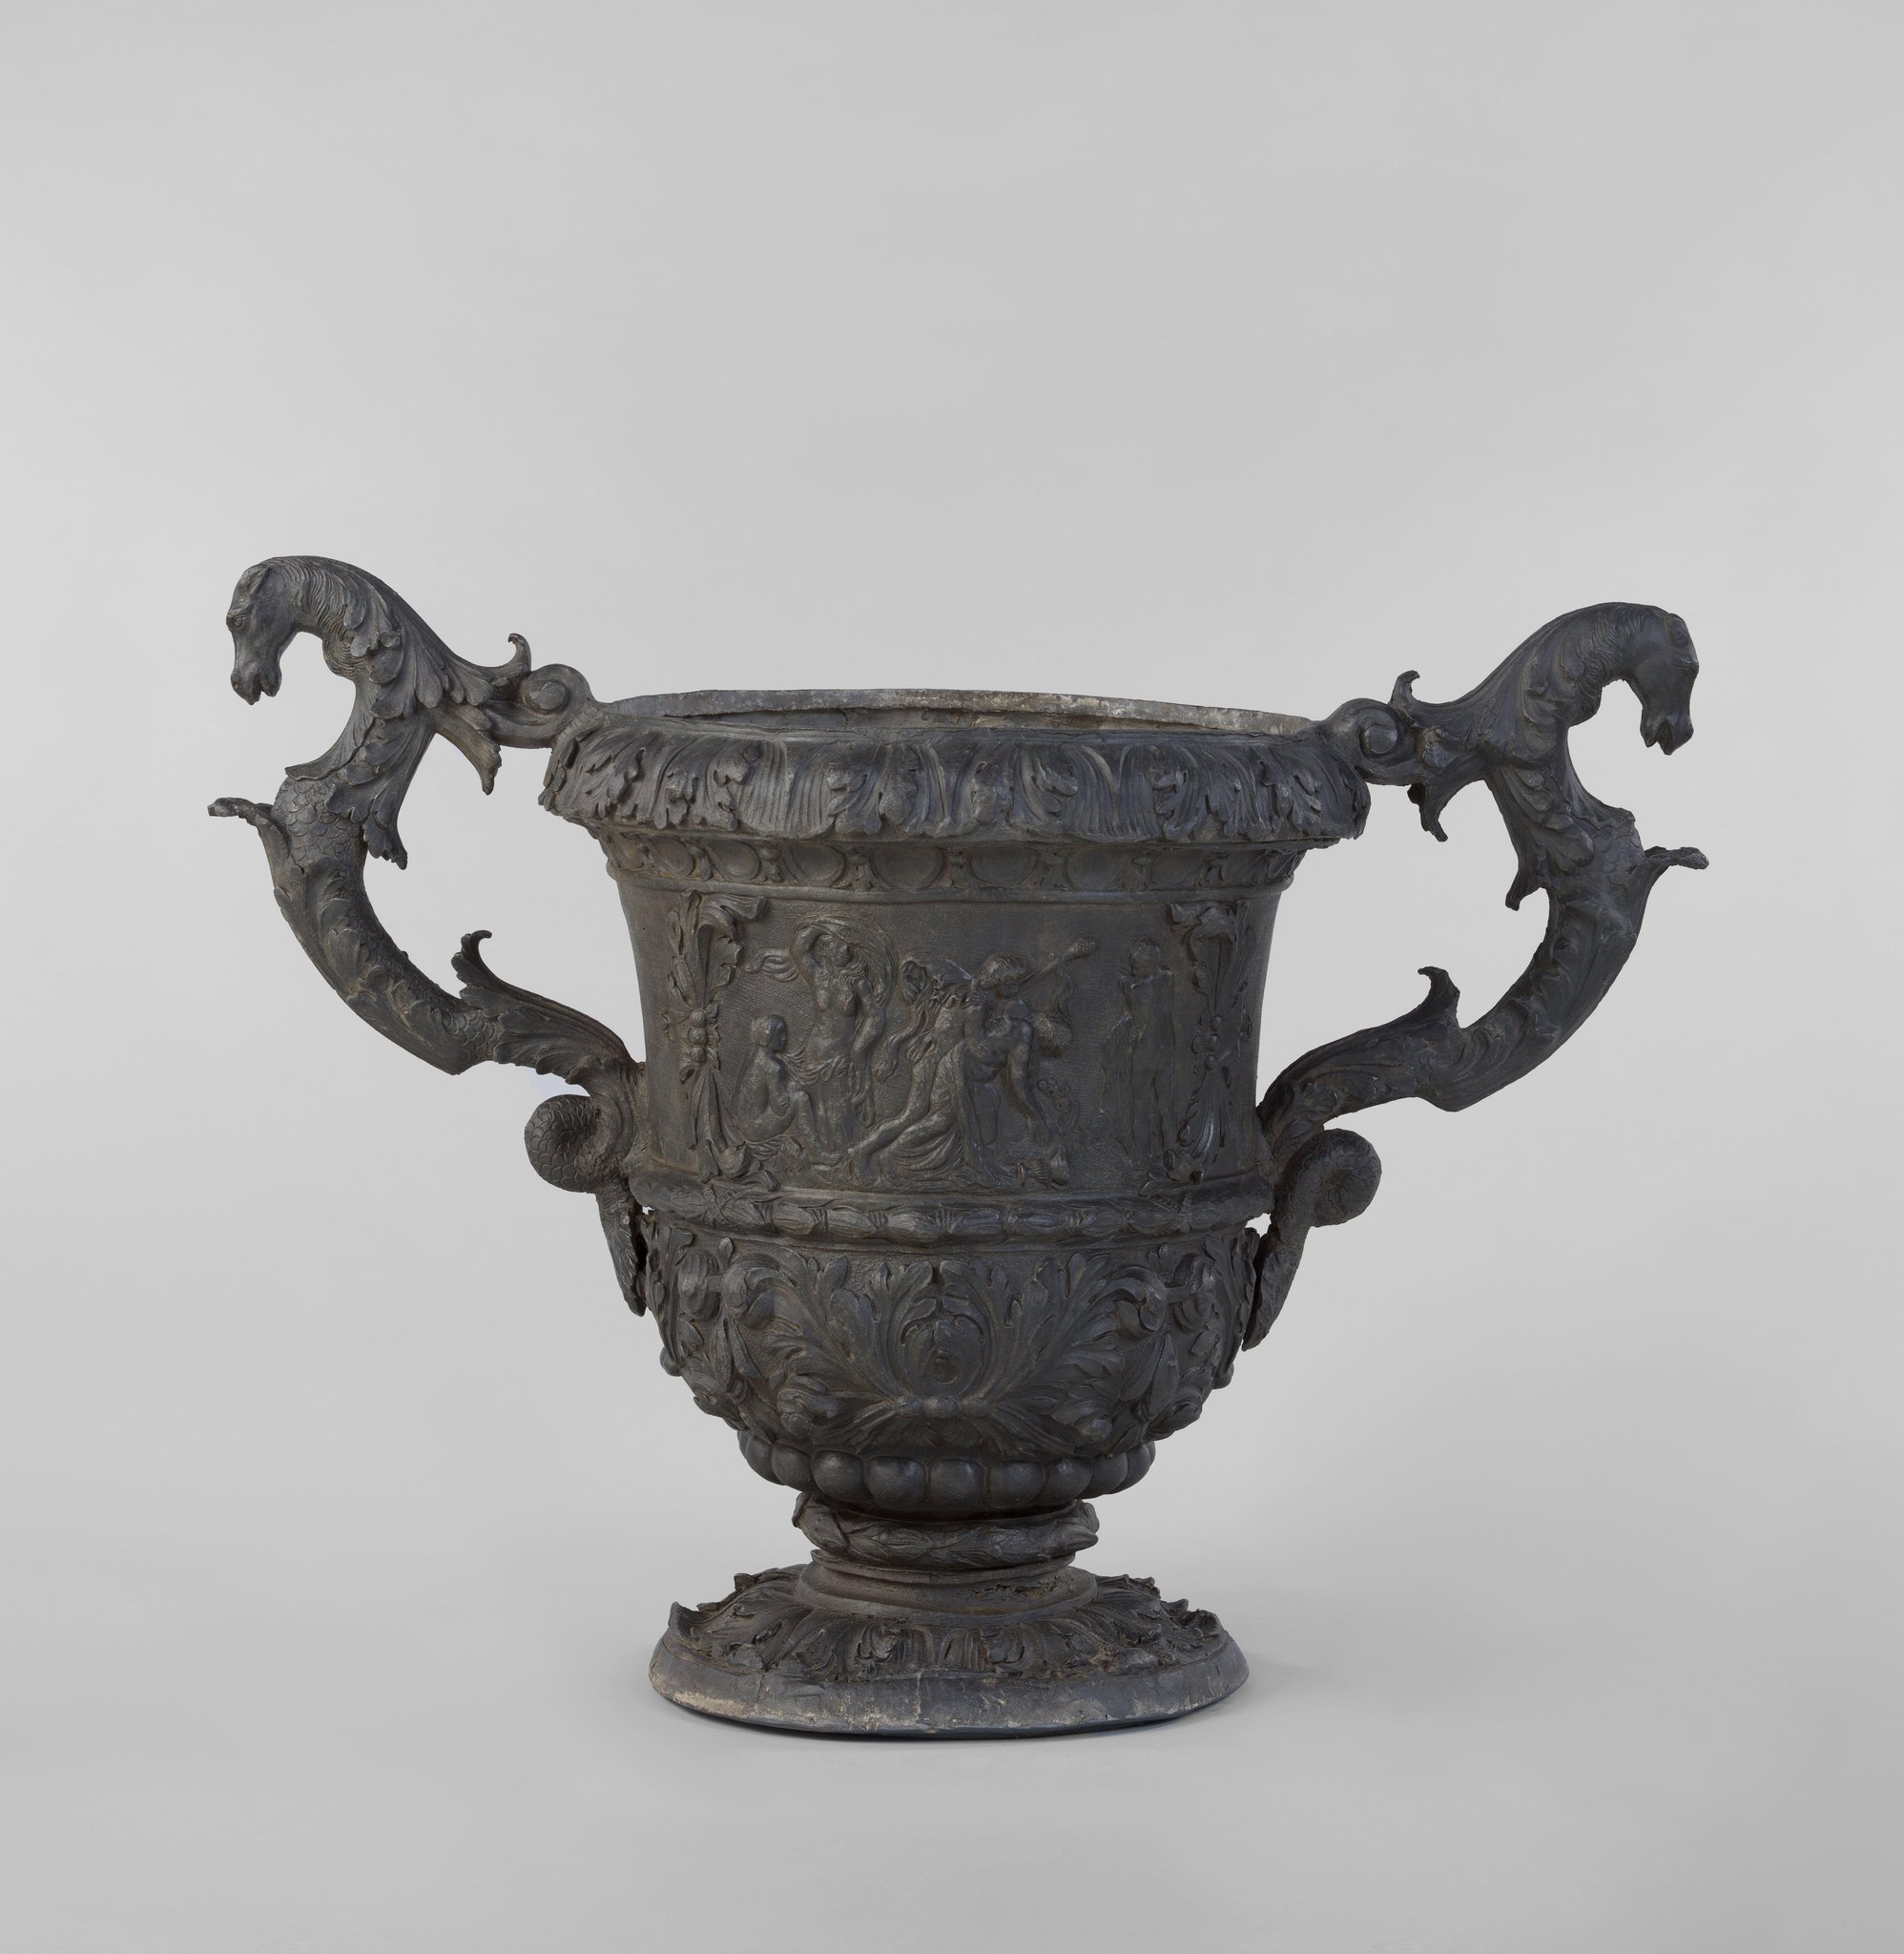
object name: vase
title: Bloempot met voorstelling van Bacchus, Silenus en drie bacchantes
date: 1680-1720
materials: lead, zinc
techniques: casting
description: Loden bloemvaas in klassieke urnvorm met aan weerszijden twee S-vormige oren in de vorm van een hippocamp. De vaas is opgebouwd op een ronde voet met acanthusbladeren, een nodus bestaande uit een laurierkrans en een gelobde rand die het vaaslichaam steunt. Het lichaam is opgebouwd uit een rand van acanthusbladeren, een lauwerkrans, een breed fries met aan weerszijden een identieke bacchische voorstelling met een dronken Sileen, ondersteund door een jonge bacchant en met drie bacchantes. Boven dit fries een smallere rand met 'egg and dart'-relief en een omgeslagen rand van symmetrische acanthusbladeren ter afsluiting. De vaas heeft een losse, zinken binnen-emmer.